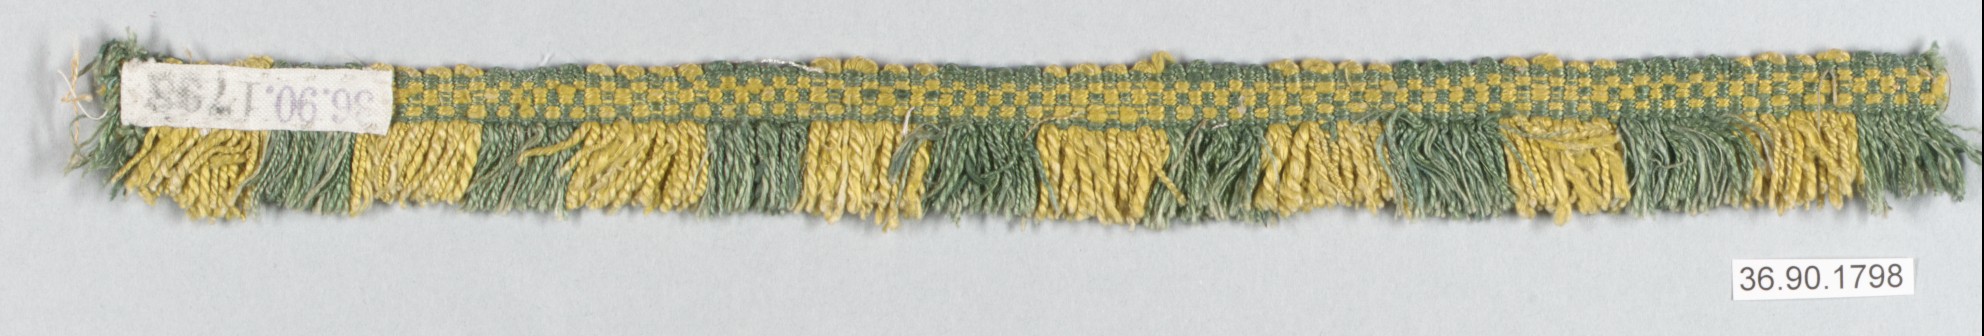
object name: fringe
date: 1734-1766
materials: silk